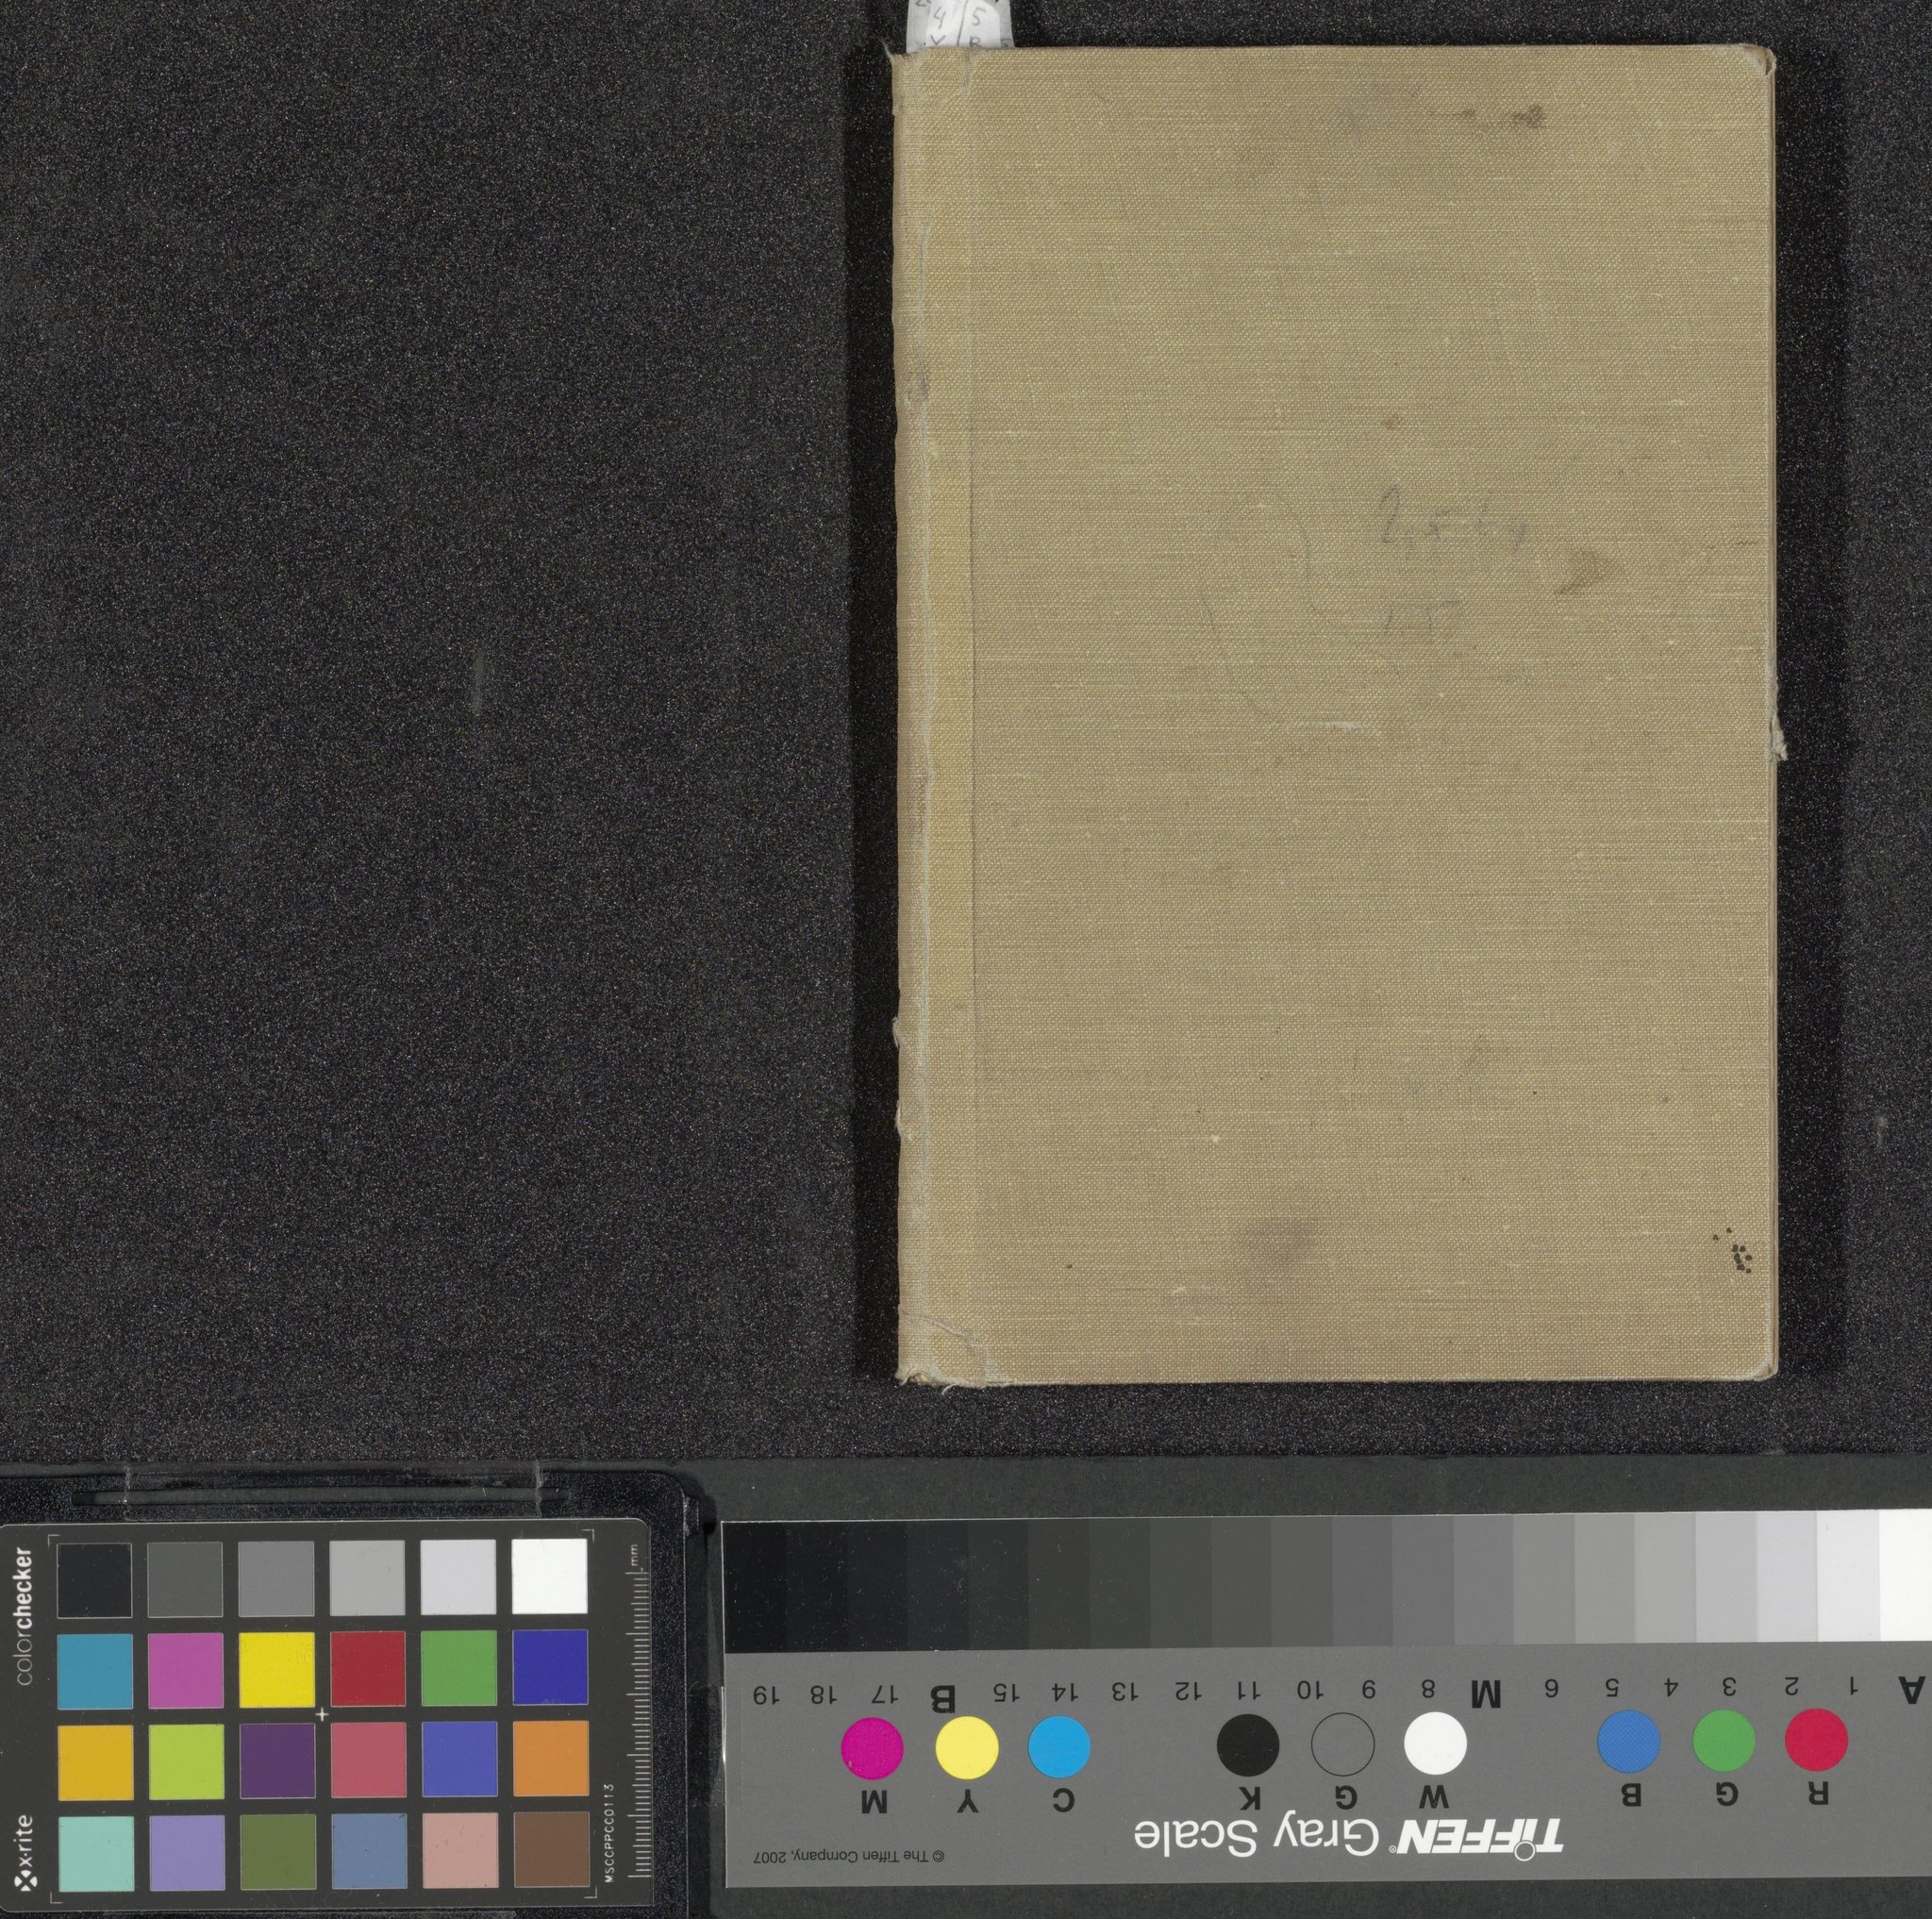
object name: sketchbook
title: Schetsboek met 73 bladen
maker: cornelis vreedenburgh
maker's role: draughtsman, print maker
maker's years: 1880-1946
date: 1890-1946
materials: cardboard, chalk, ink, linen, paper, pencil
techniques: pen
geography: amsterdam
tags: sailing-ship, sailing-boat, automobile, street (+ city(-scape) with figures, staffage), amsterdam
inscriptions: collector's mark: Lugt 2228a, retailer's mark: ‘J. H. van BEEK/ specialiteit in/ KUNSTSCHILDERS ARTIKELEN/ Stadhouderskade 63 - TEl 21670/ AMSTERDAM’, factory mark: ‘SKETCHER'S/ NOTE BOOK/ SERIES A 42/ containing 80 leaves of good white paper./ MANUFACTURED BY/ GEO. ROWNEY & CO., LONDON, W., ENGLAND/ SIZE No. 2- 8 1/2 x 5 1/2 inches./ Dimensions de l'album 14 x 10 cm.’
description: De volgende bladen uit het schetsboek zijn blanco: 1(V) t/m 4(V), 5, 6(V) t/m 30(V), 31, 32(V) t/m 41(V), 42, 43(V) t/m 47(V), 49(V), 51(V), 52(V), 53 t/m 55, 56(R) t/m 59(R), 60, 61(V) t/m 64(V), 65 t/m 69, 70(R) t/m 73(R).